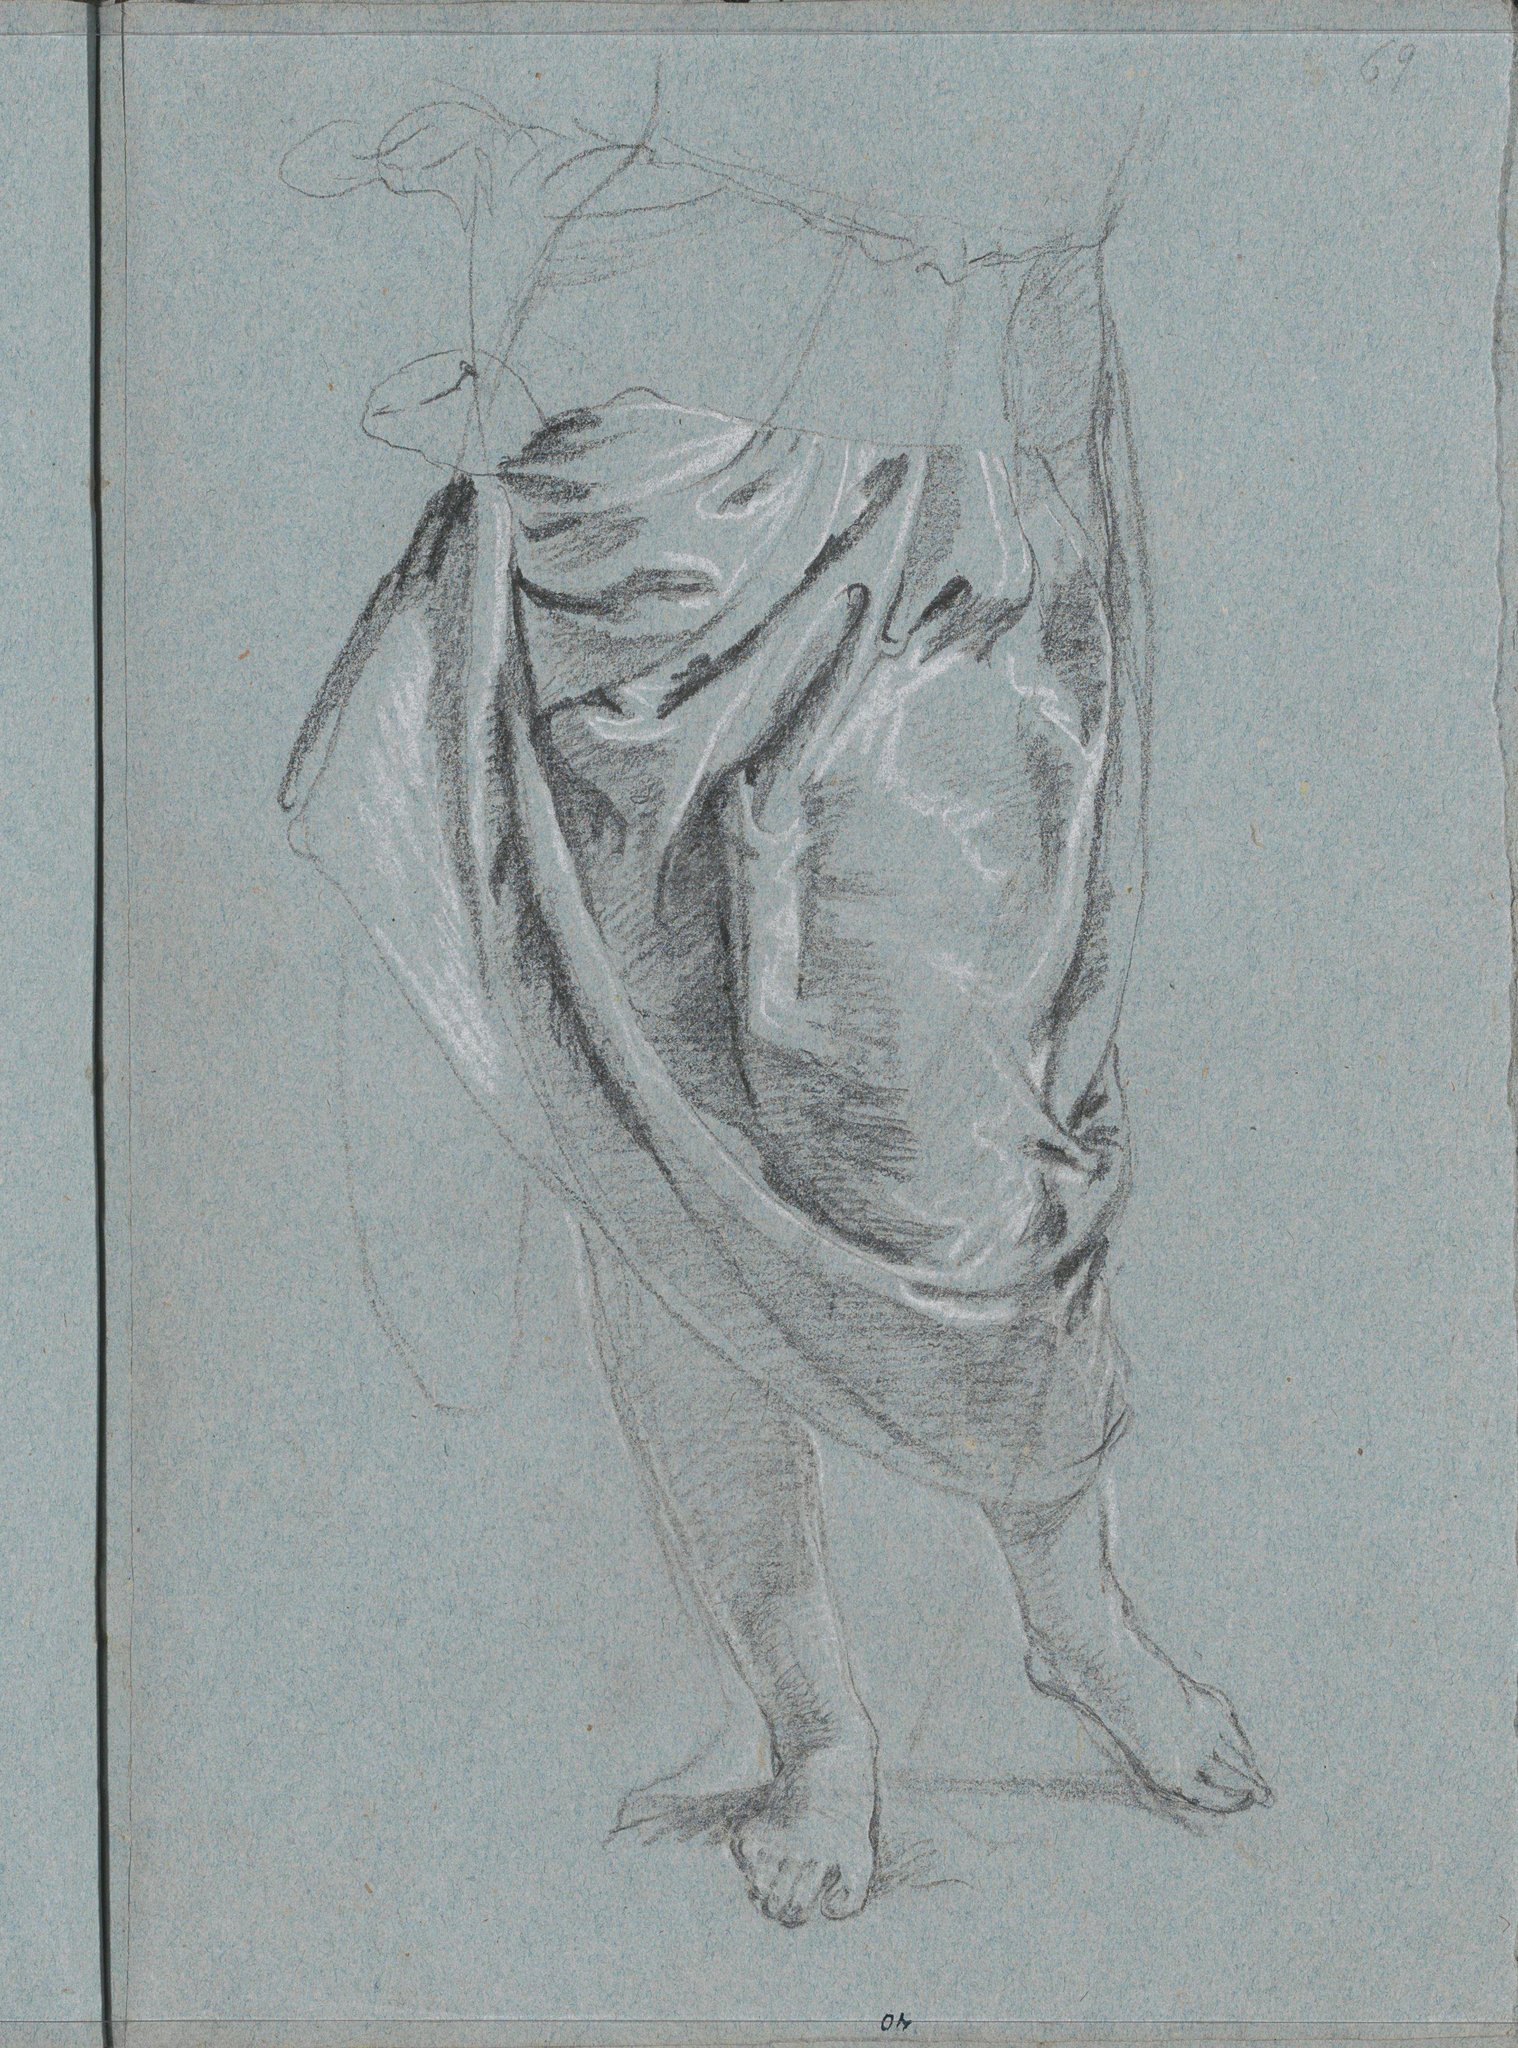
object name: sketchbook leaf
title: Onderlichaam met draperie rond de heupen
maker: lorenzo baldissera tiepolo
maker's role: draughtsman, print maker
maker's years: 1736-1776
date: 1751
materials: chalk, paper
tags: lower leg, drapery, draped garment, 'gewandgebung'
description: Bladzijde 69 uit een schetsboek met 158 bladzijden.